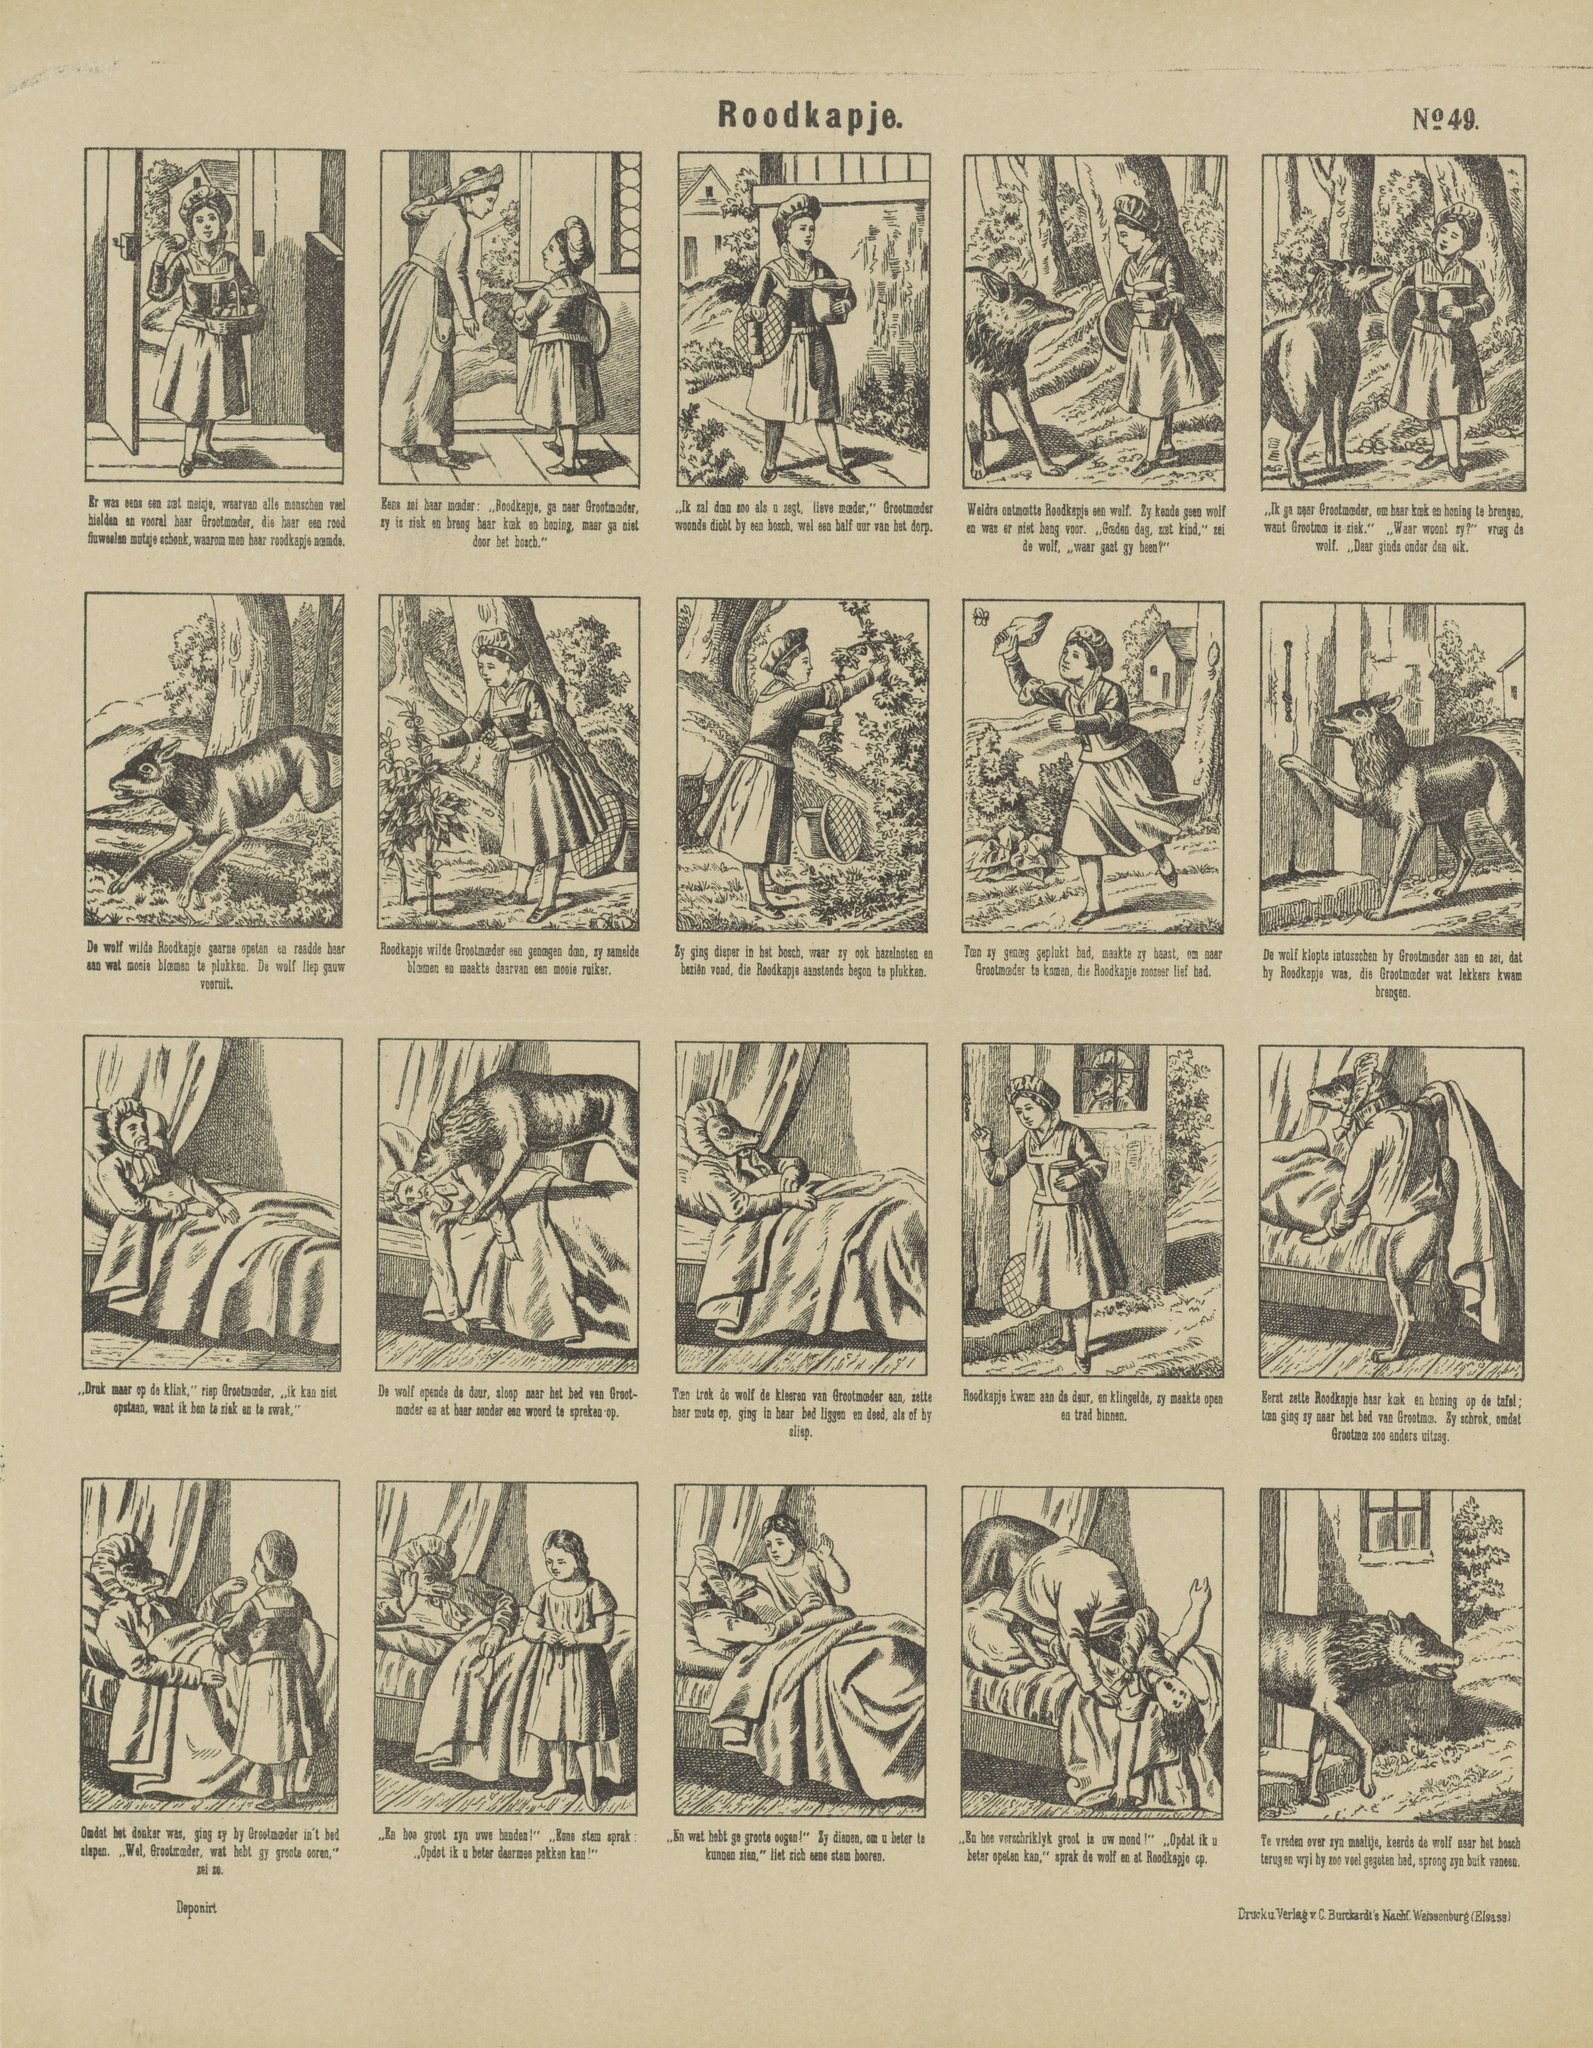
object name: popular print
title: Roodkapje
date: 1889-1906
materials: paper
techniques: letterpress printing, lithograph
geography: wissembourg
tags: tales and fairy tales: little red riding-hood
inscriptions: collector's mark: Lugt 2760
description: Blad met 20 voorstellingen uit het sprookje van Roodkapje. Onder elke afbeelding een onderschrift. Genummerd rechtsboven: No. 49.